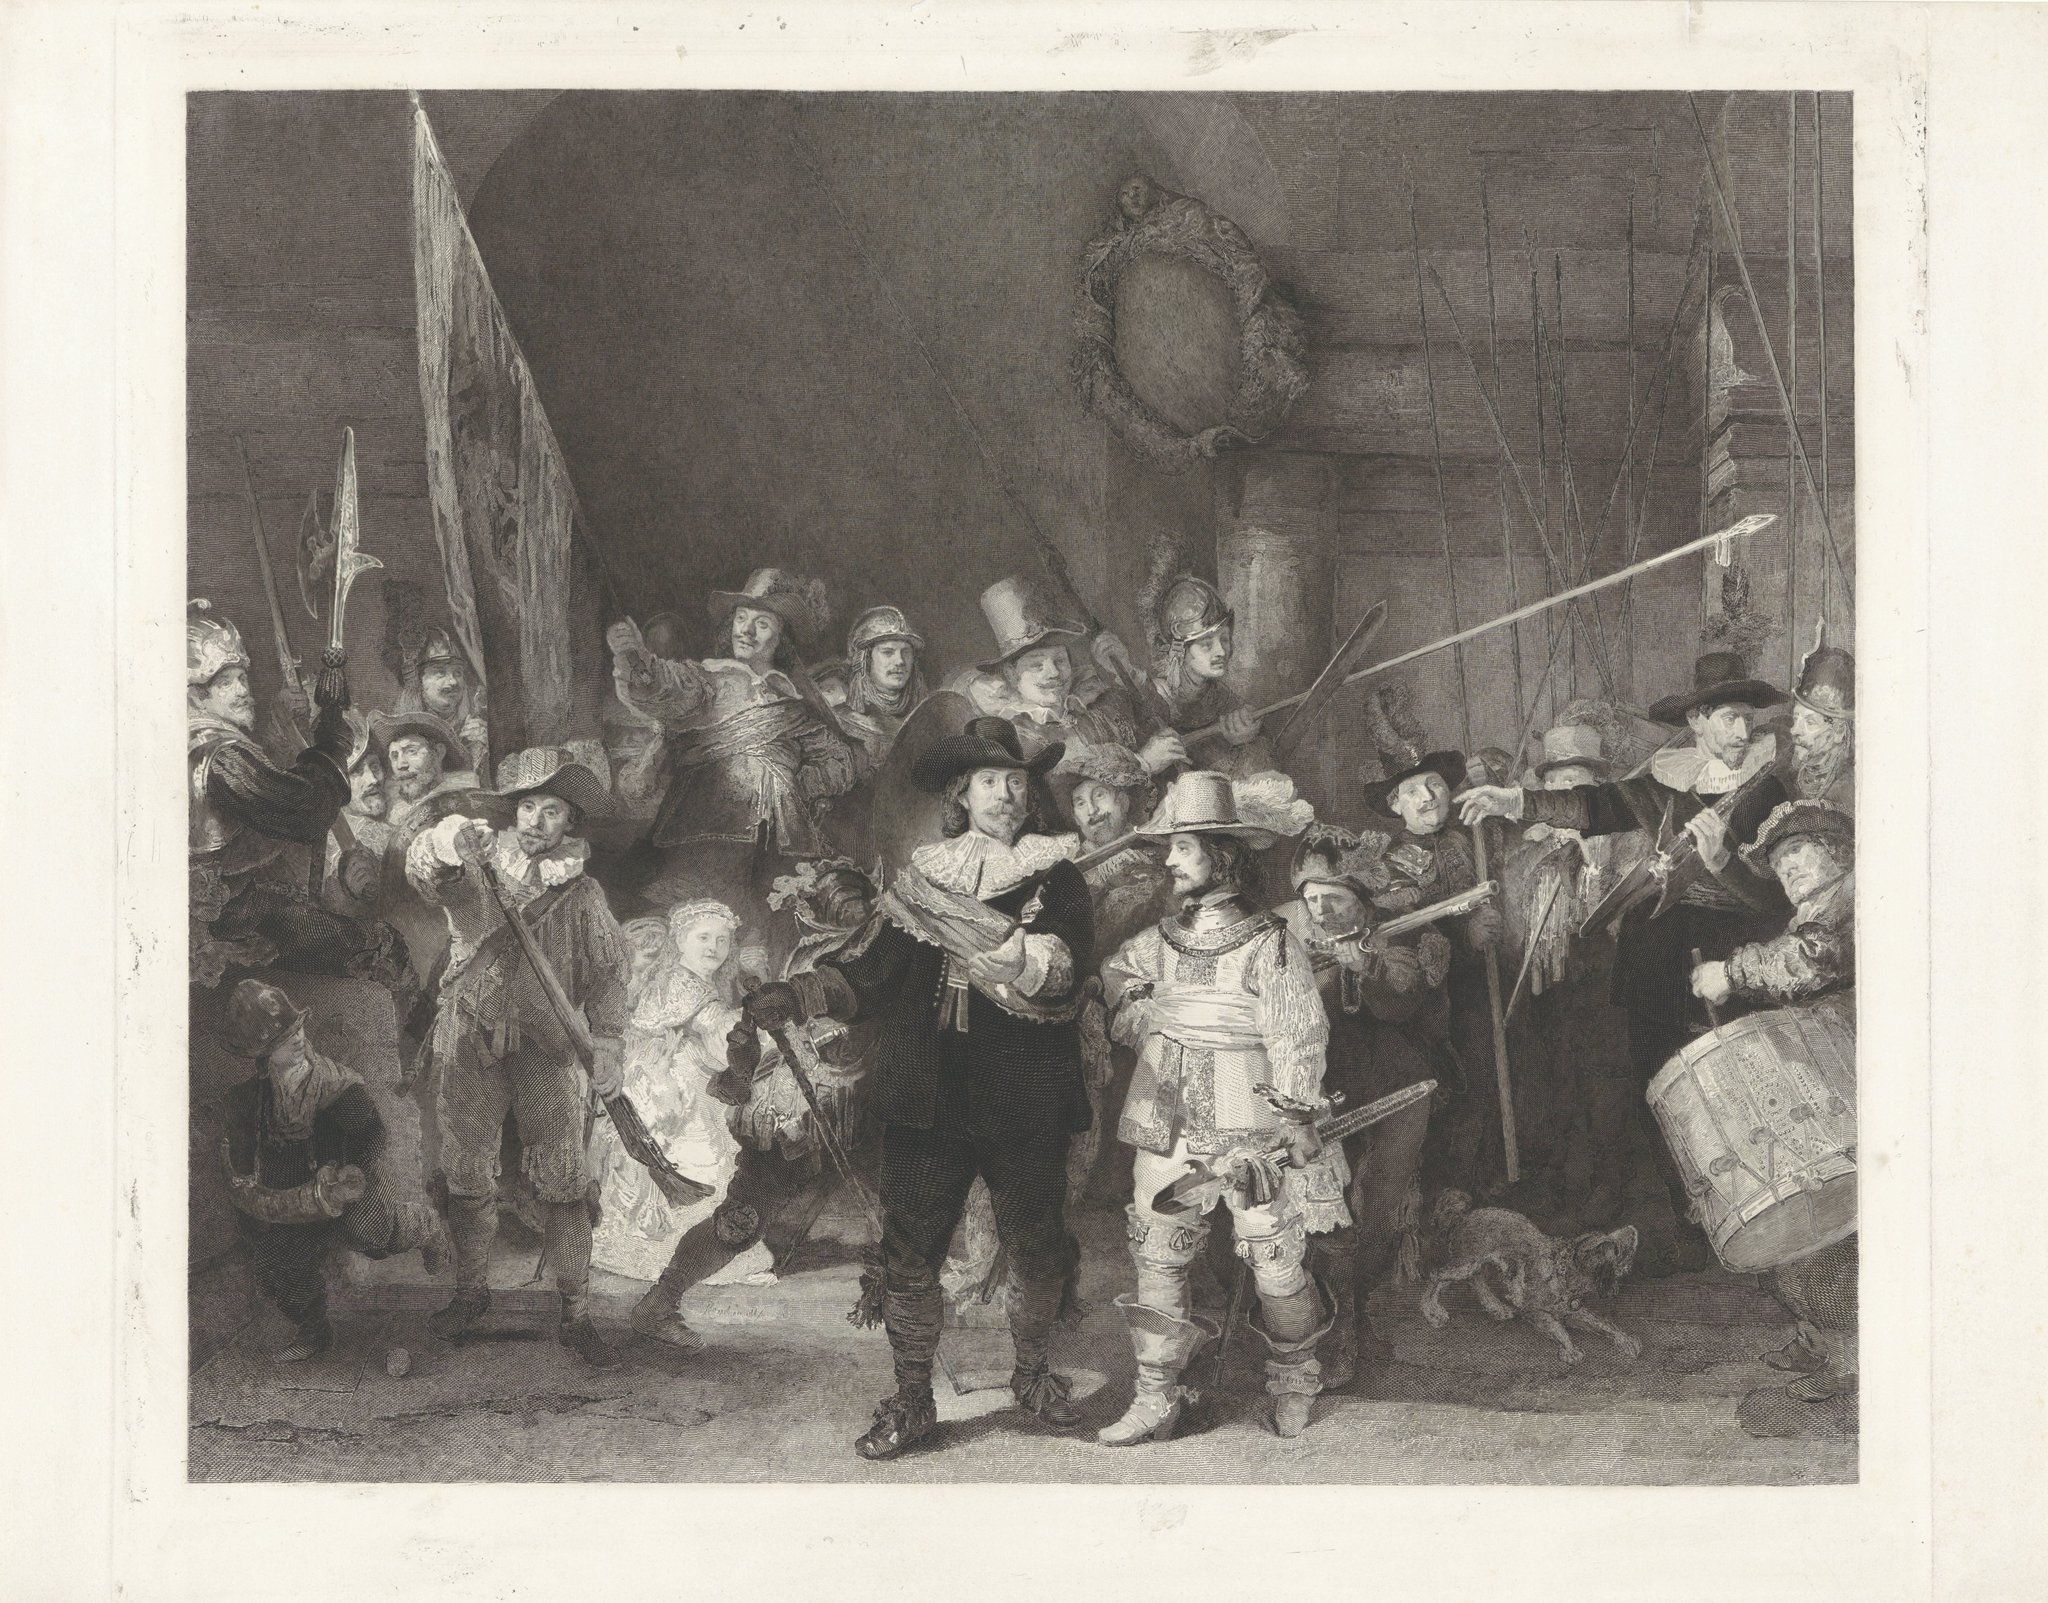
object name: print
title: Het korporaalschap van kapitein Frans Banninck Cocq en luitenant Willem van Ruytenburch, bekend als de 'Nachtwacht'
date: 1863-1864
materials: paper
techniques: drypoint, engraving, etching, roulette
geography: amsterdam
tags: proclamation of peace, celebration meal, feast, banquet, festivities on events of national importance, picture, painting, land forces (+ citizen soldiery, civil guard, citizen militia), historical events and situations, dog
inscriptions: collector's mark: Lugt 2228